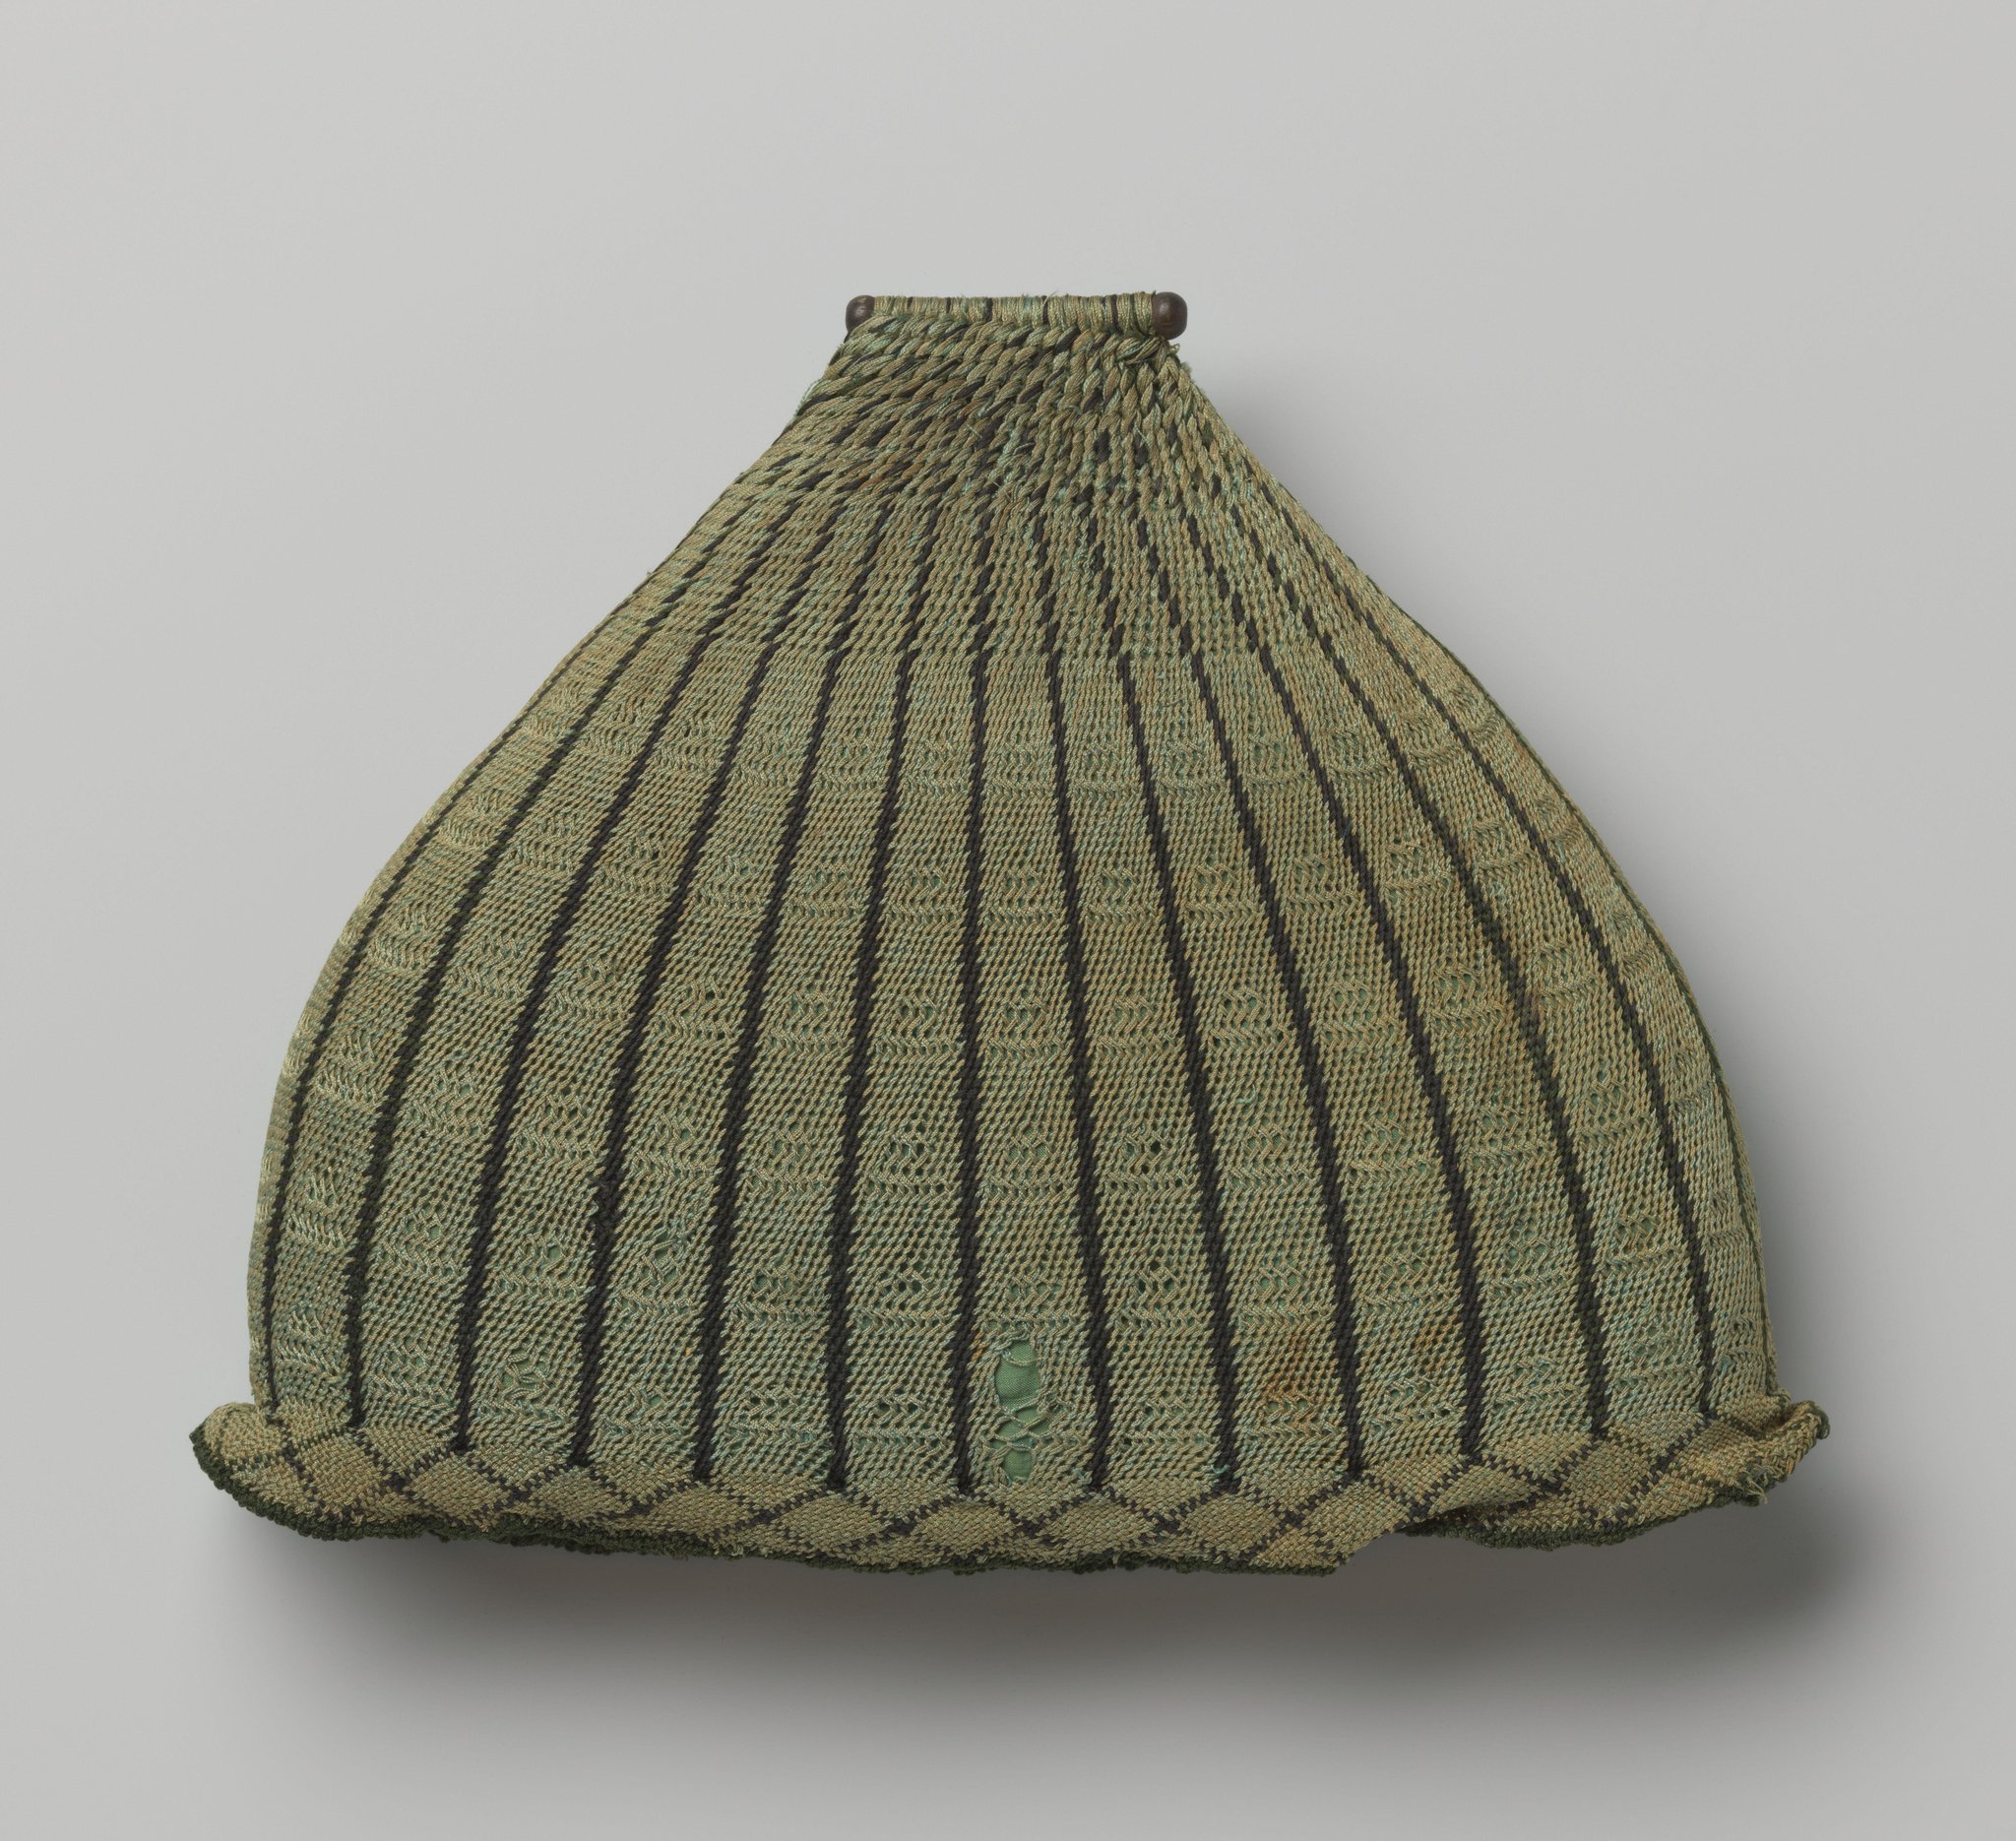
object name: theemuts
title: Theemuts van groen-zwart gestreept brei- of vlechtwerk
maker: cornelia elisabeth siewertsz van reesema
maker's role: artisan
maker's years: 1881-1954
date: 1890-1920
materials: cotton, silk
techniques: braiding, weave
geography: netherlands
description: Theemuts van groen-zwart gestreept brei- of vlechtwerk, gevoerd met groen zijde en aan de binnenzijde met bruinoranje katoen. Enkele gaten en gevlekt zowel aan de buiten- als binnenzijde.